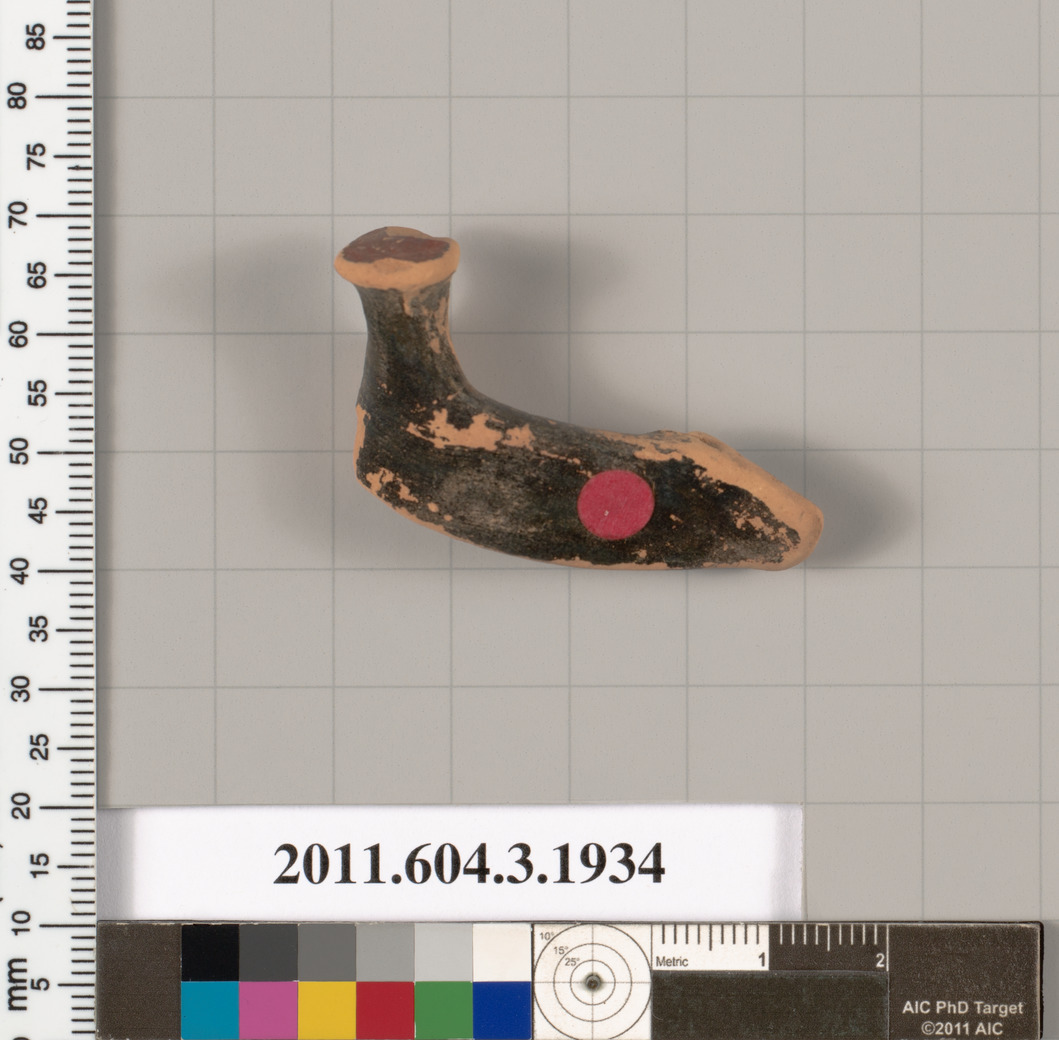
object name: kylix fragment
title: Terracotta fragment of a kylix (drinking cup)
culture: greek, attic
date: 550-526 BCE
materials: terracotta